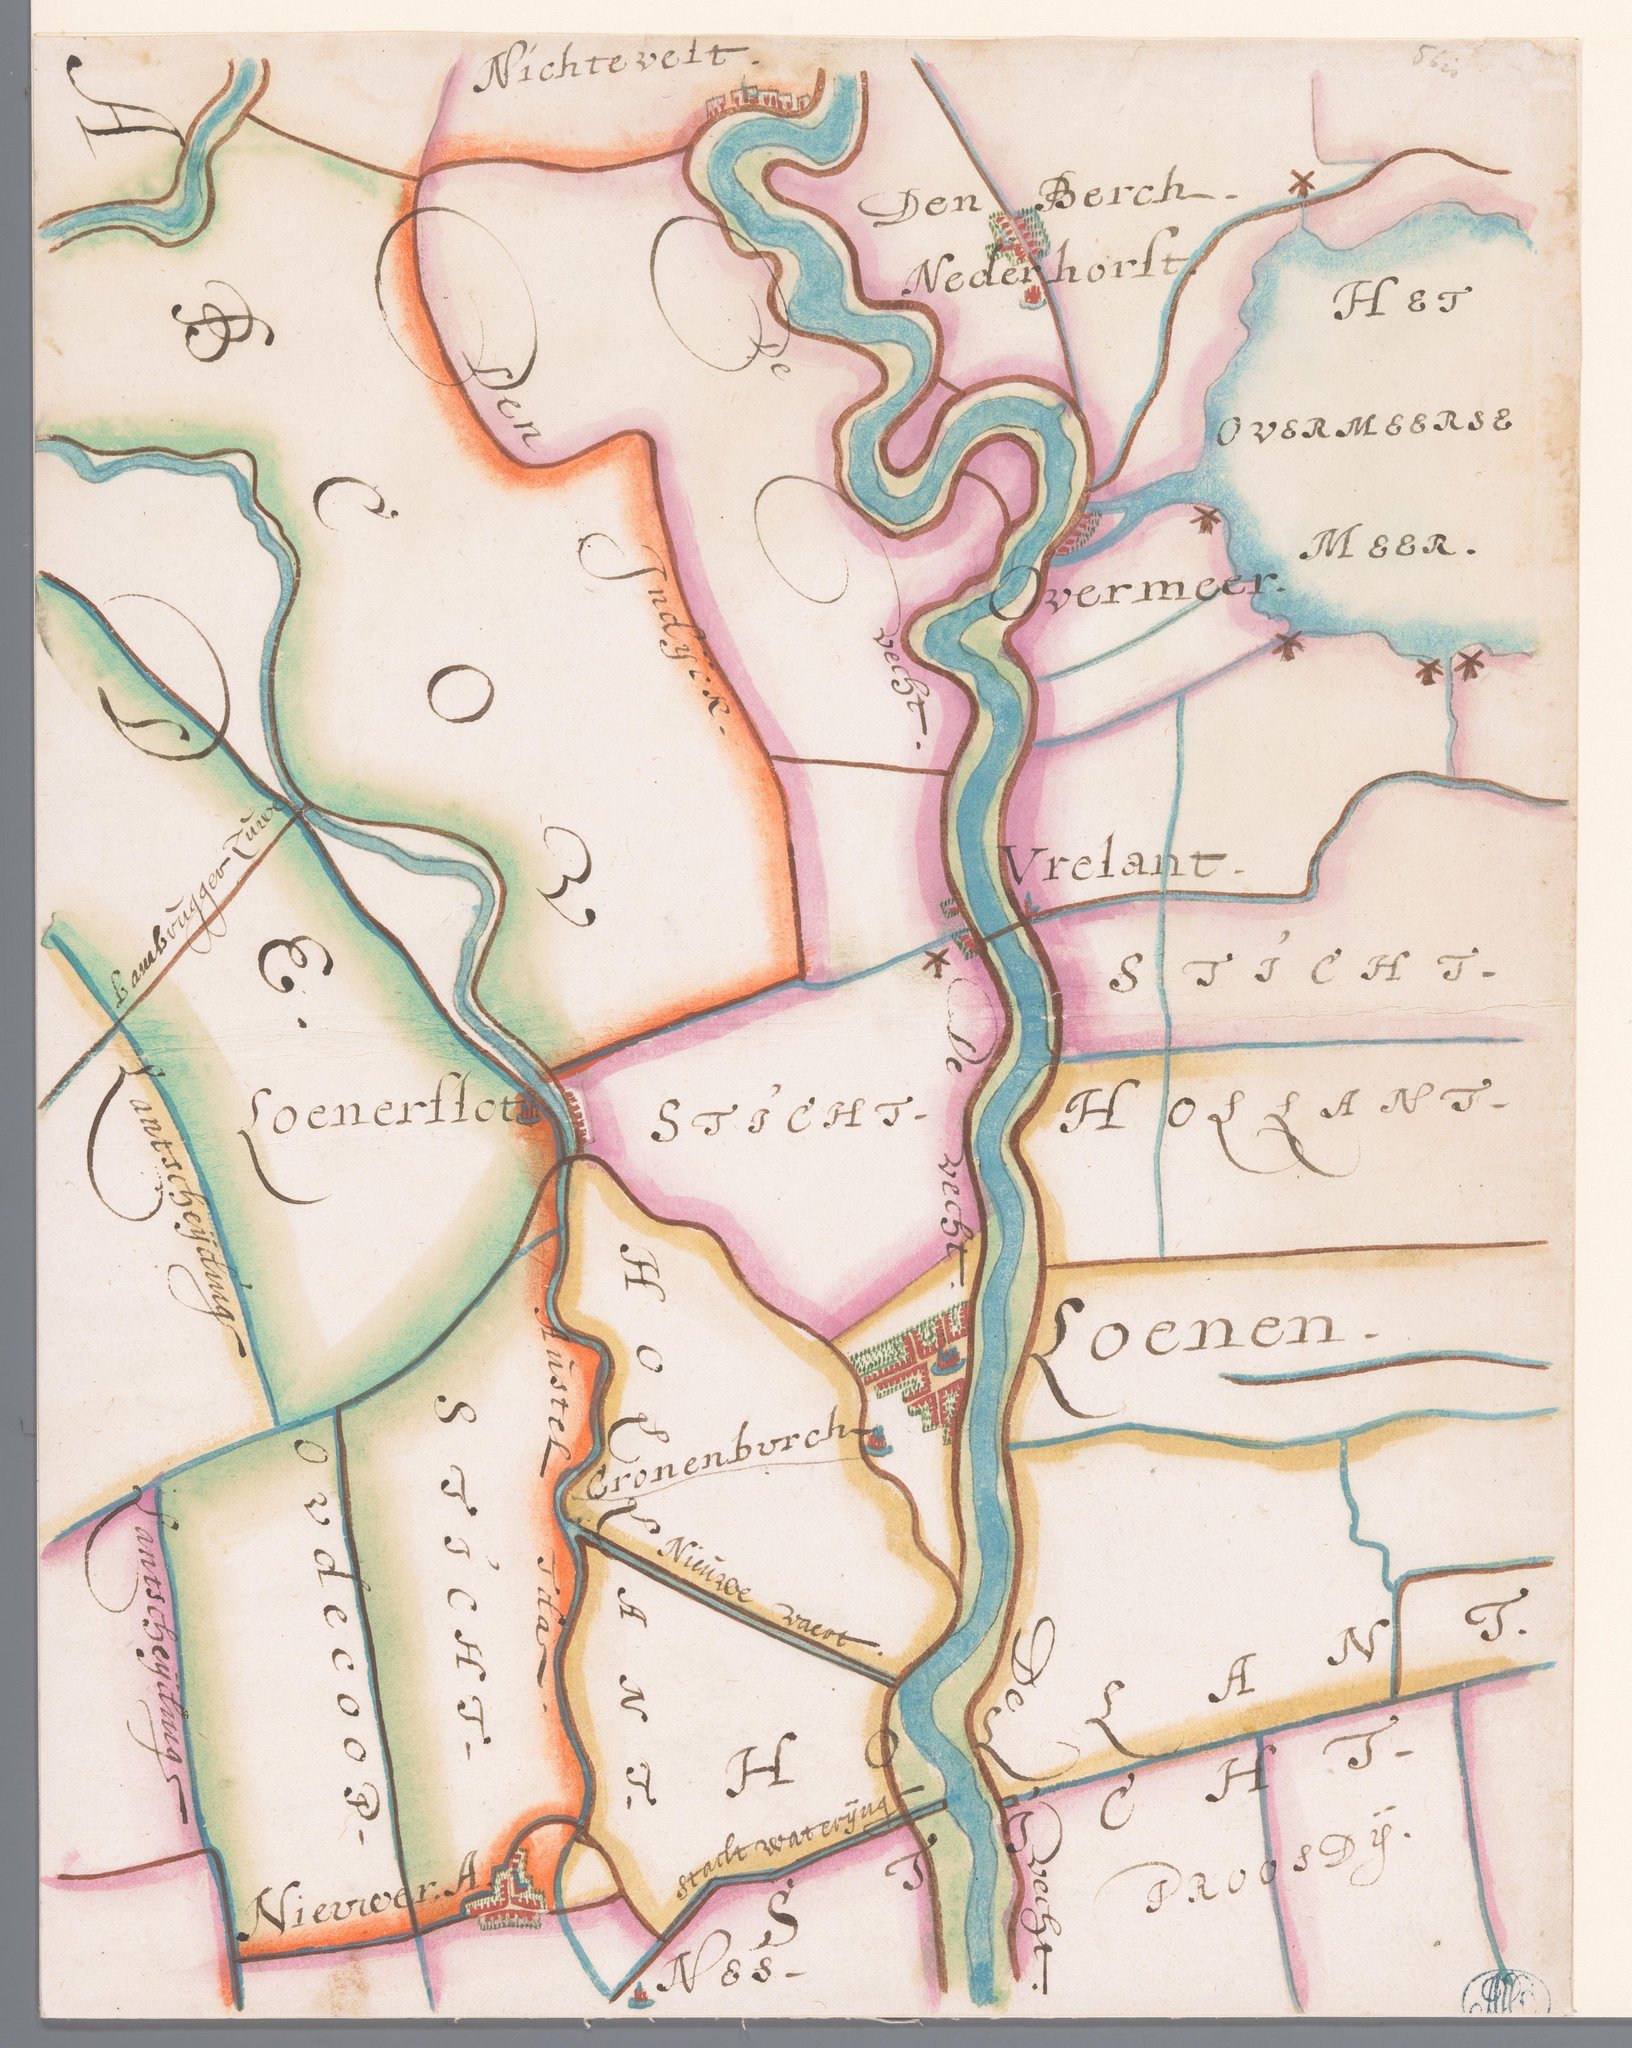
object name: map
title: Deel van een kaart van het Hoogheemraadschap van Rijnland, met Loenen en omgeving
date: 1615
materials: ink, paint, paper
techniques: brush, pen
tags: maps of separate countries or regions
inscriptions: collector's mark: Lugt 195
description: Deel van een kaart van Rijnland, bestaande uit 27 delen.